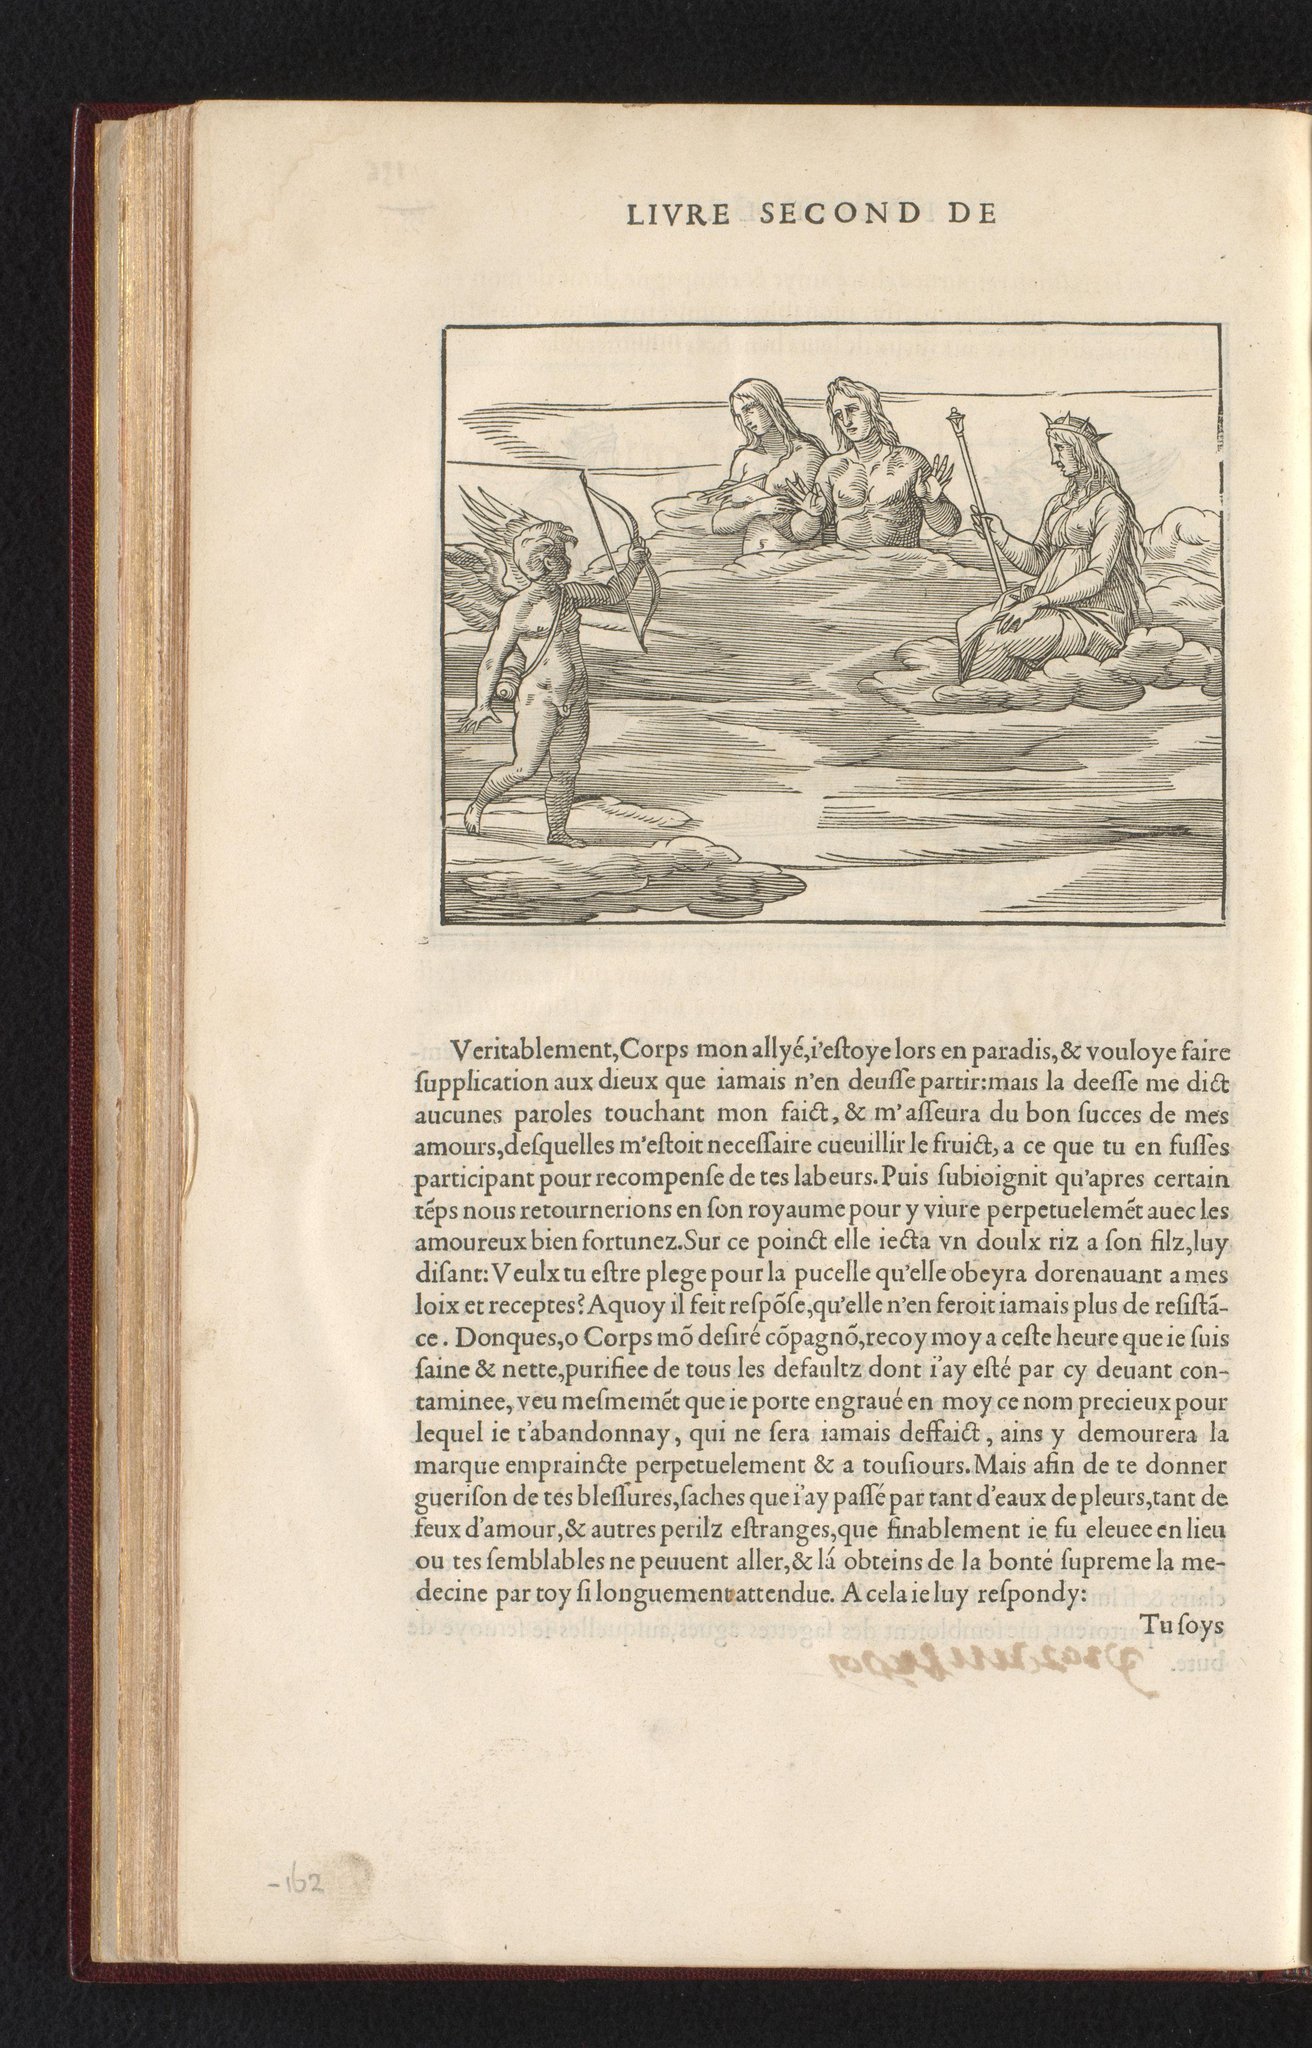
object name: print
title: Cupido's pijl doorboort de borst van Polia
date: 1546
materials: paper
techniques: letterpress printing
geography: paris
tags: cupid shooting a dart, (scenes from) specific works of literature: colonna, hypnerotomachia poliphili, the soul examined; the soul before its judge, representations ~ goddesses, demi-goddesses, heroines, etc. (greek religion)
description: Prent uit: Colonna, Francesco. Hypnerotomachie ou discours du songe de Poliphile, deduisant comme amour le combat a l'occasion de Polia. Parijs: Jacques Kerver, 1546, verso fol. 155.